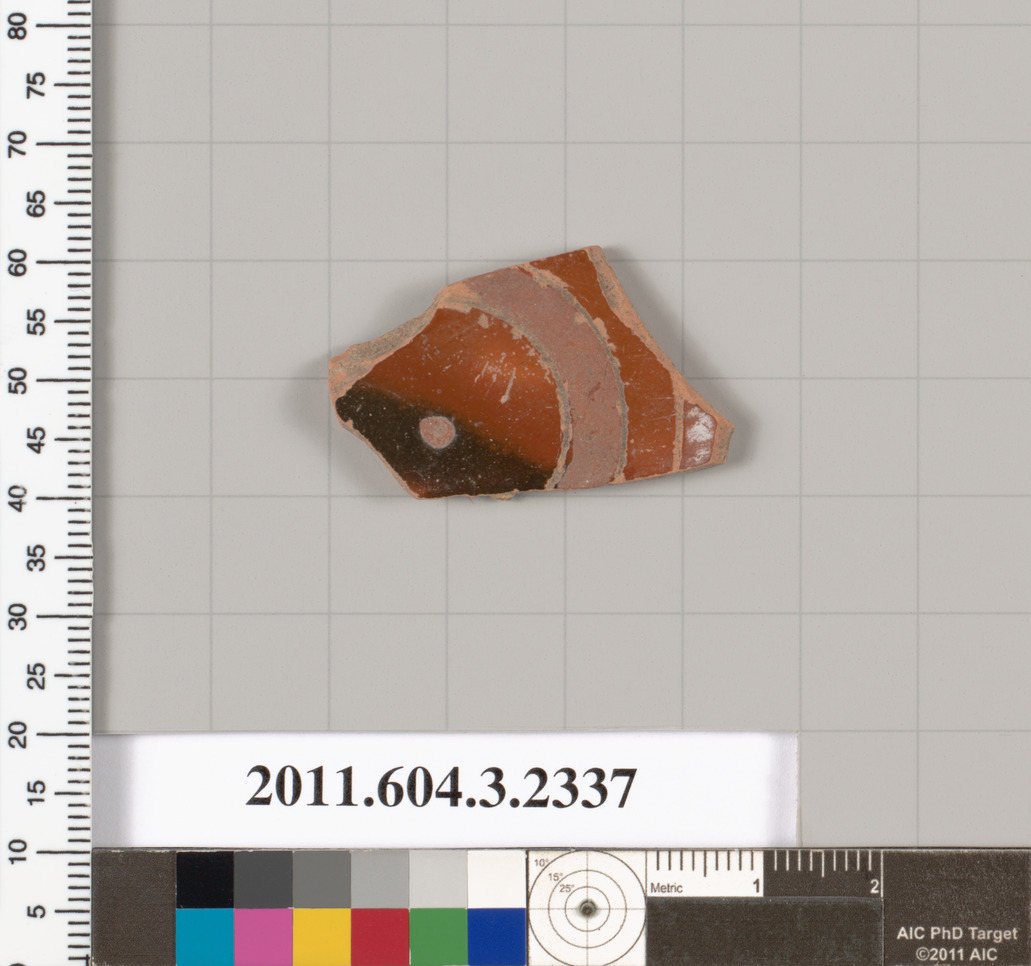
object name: kylix fragment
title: Terracotta fragment of a kylix: eye-cup (drinking cup)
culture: greek, attic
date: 530-510 BCE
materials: terracotta